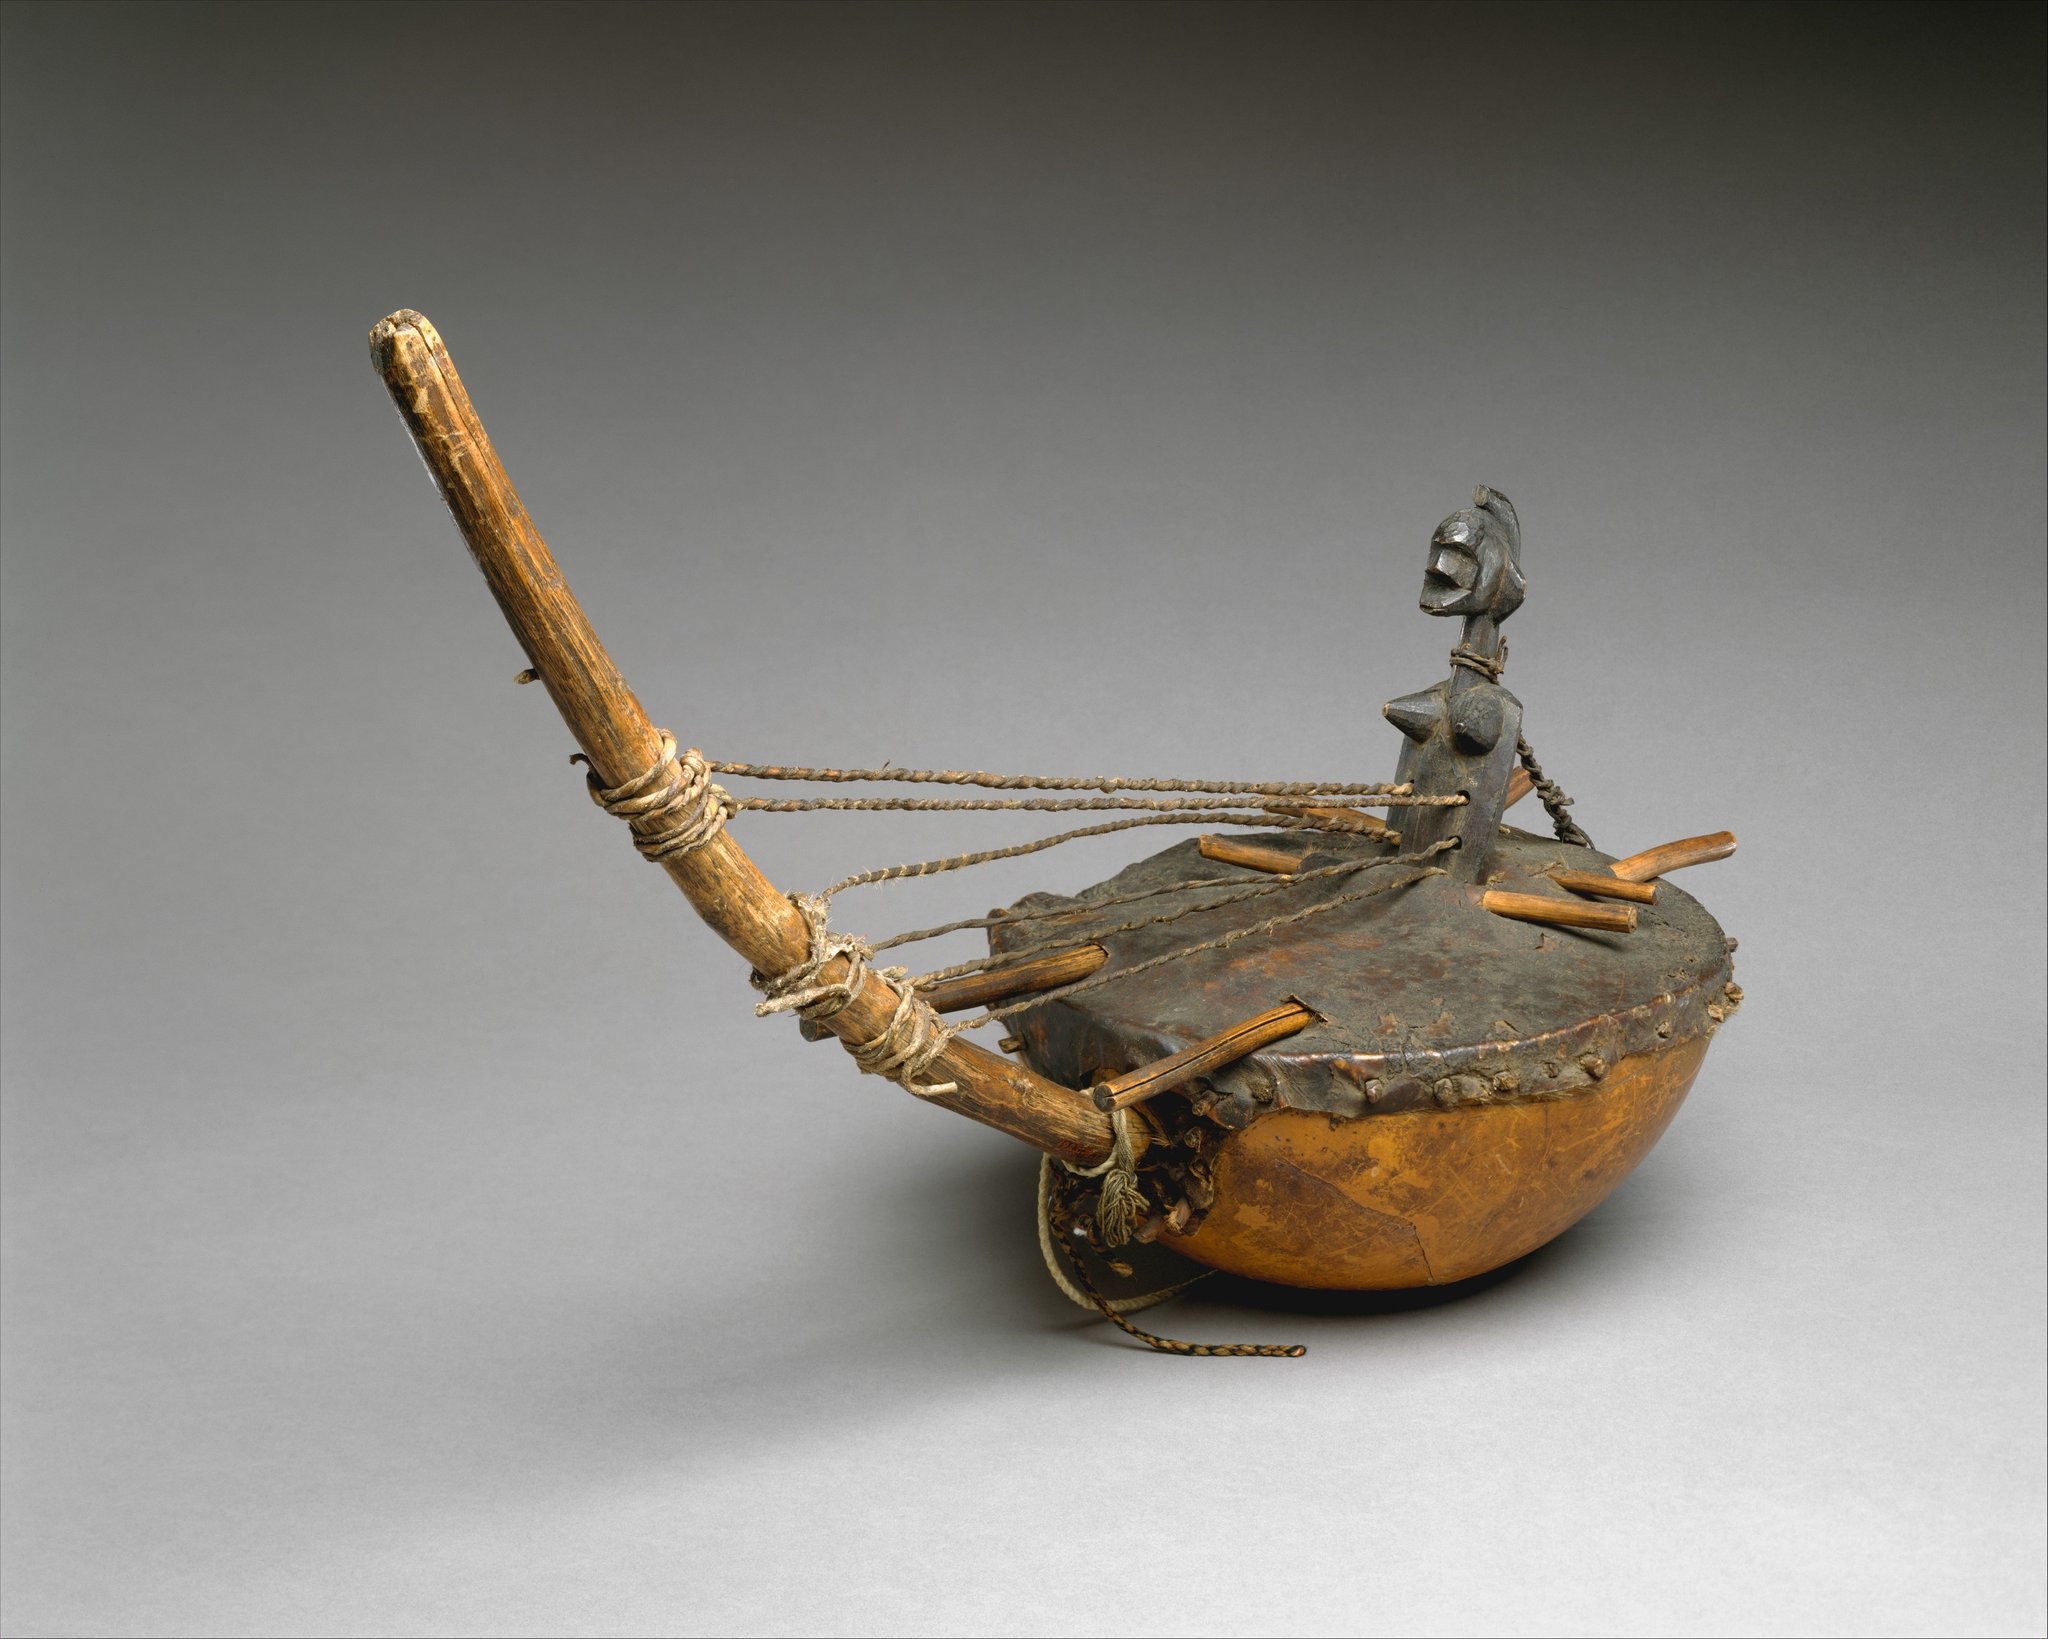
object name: korikaariye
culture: senufo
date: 1801-1900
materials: skin, wood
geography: ivory coast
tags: women